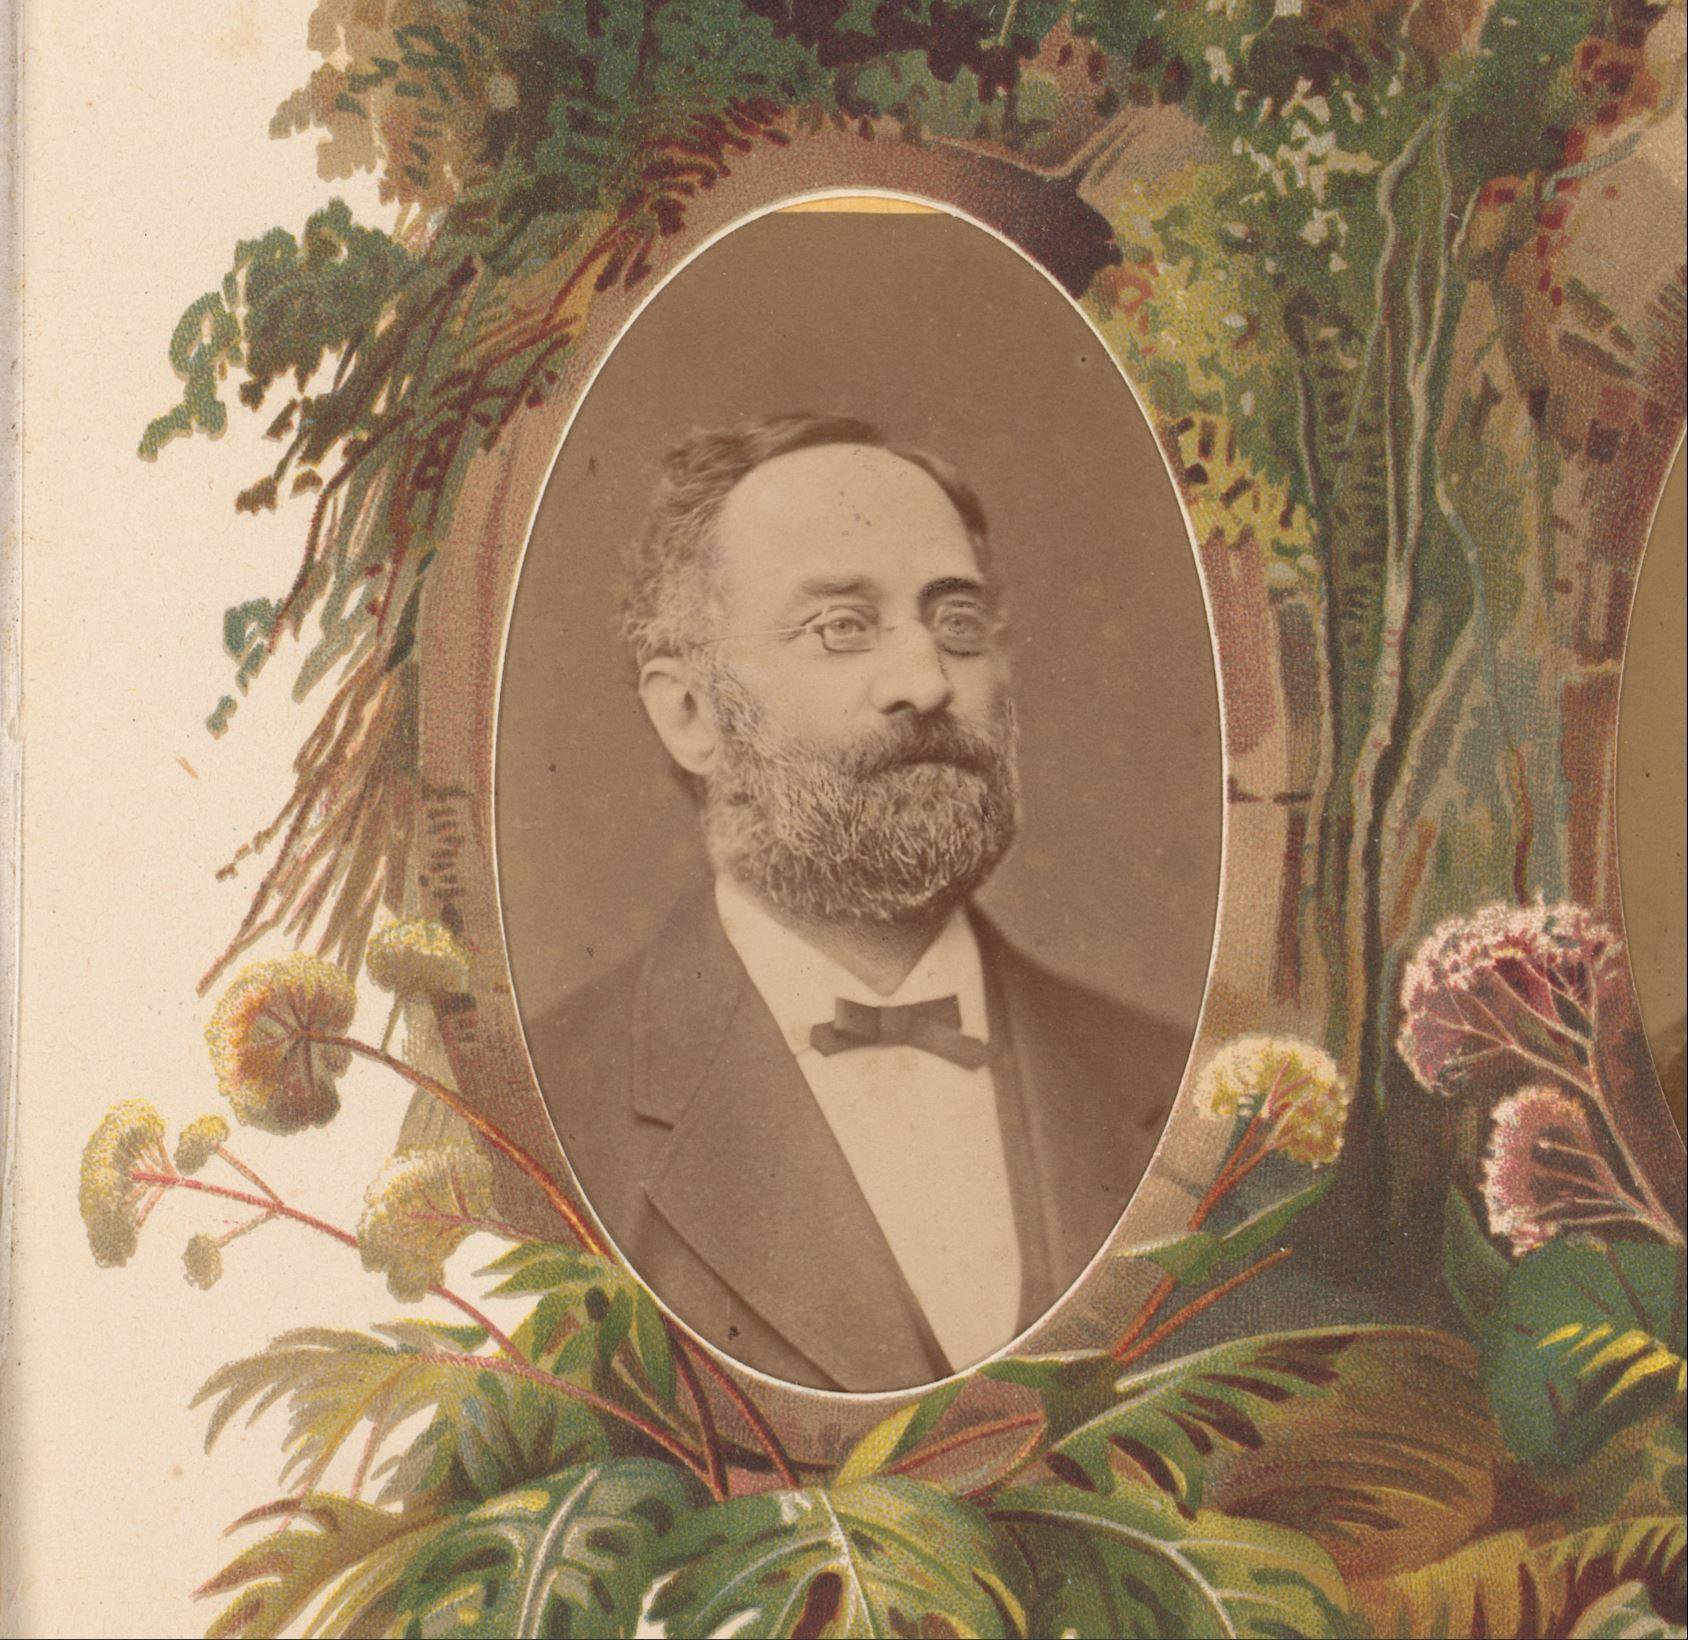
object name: photograph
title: Portret van een man met baard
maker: julius jr. ortgies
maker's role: fotograaf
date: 1850-1900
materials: cardboard, photographic support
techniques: albumen print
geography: bremen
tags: historical persons, beard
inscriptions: inscription: ‘Photographie/ von/ Julius Ortgies Jr./ in/ BREMEN/ am Wall No. 160./ zwischen dem Bischofs-u. Heerdenthor./ Zu Nachbestellungen wird die Originalplatte/ aufbewahrt.’